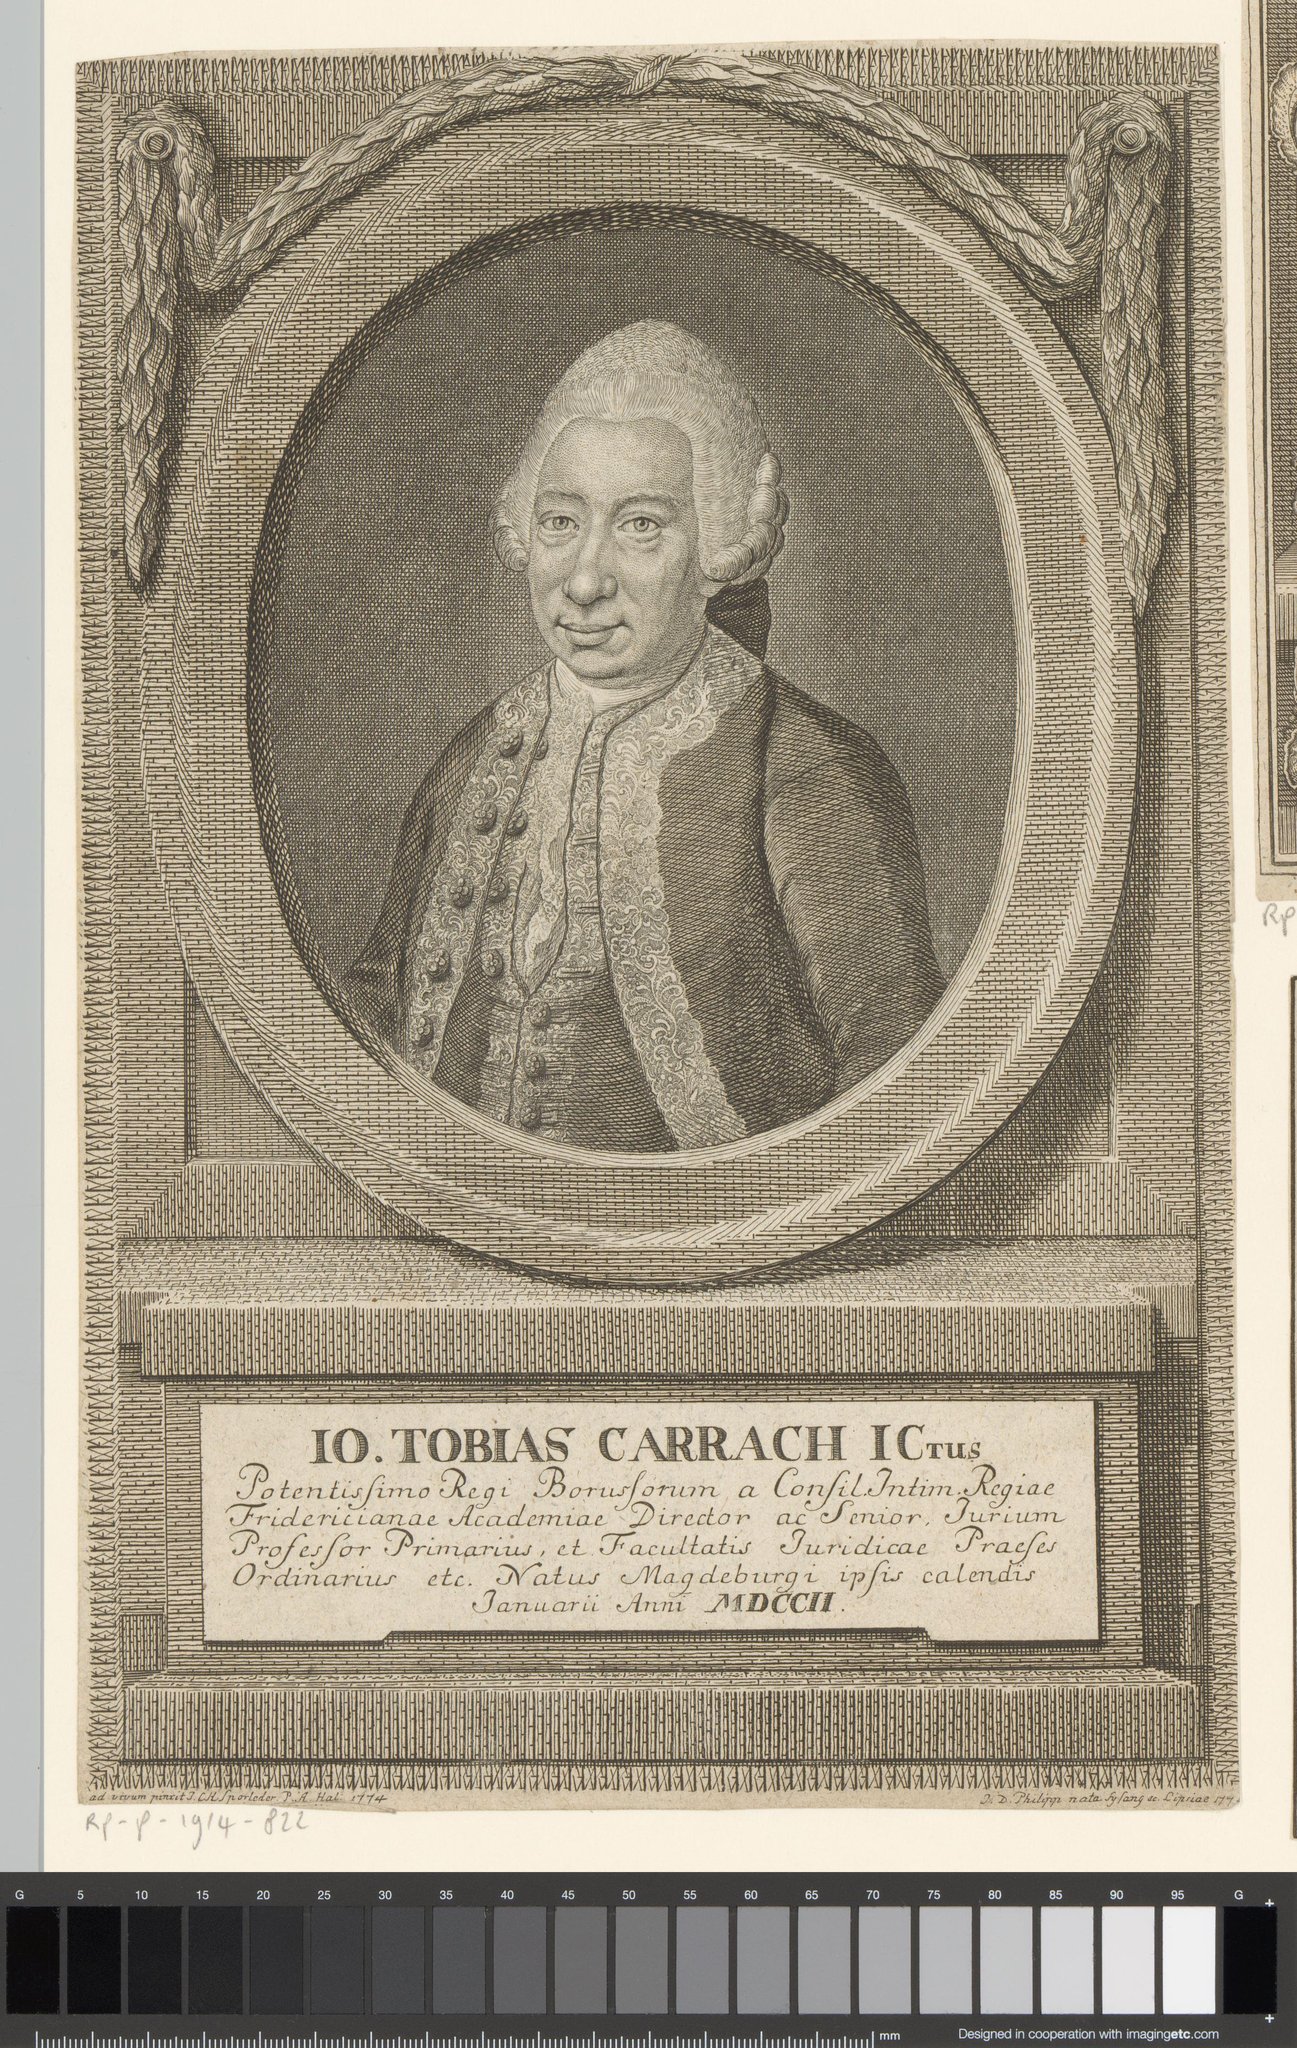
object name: print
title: Portret van Johann Tobias Carrach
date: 1774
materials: paper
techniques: engraving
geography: leipzig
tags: historical persons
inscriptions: collector's mark: Lugt 2228